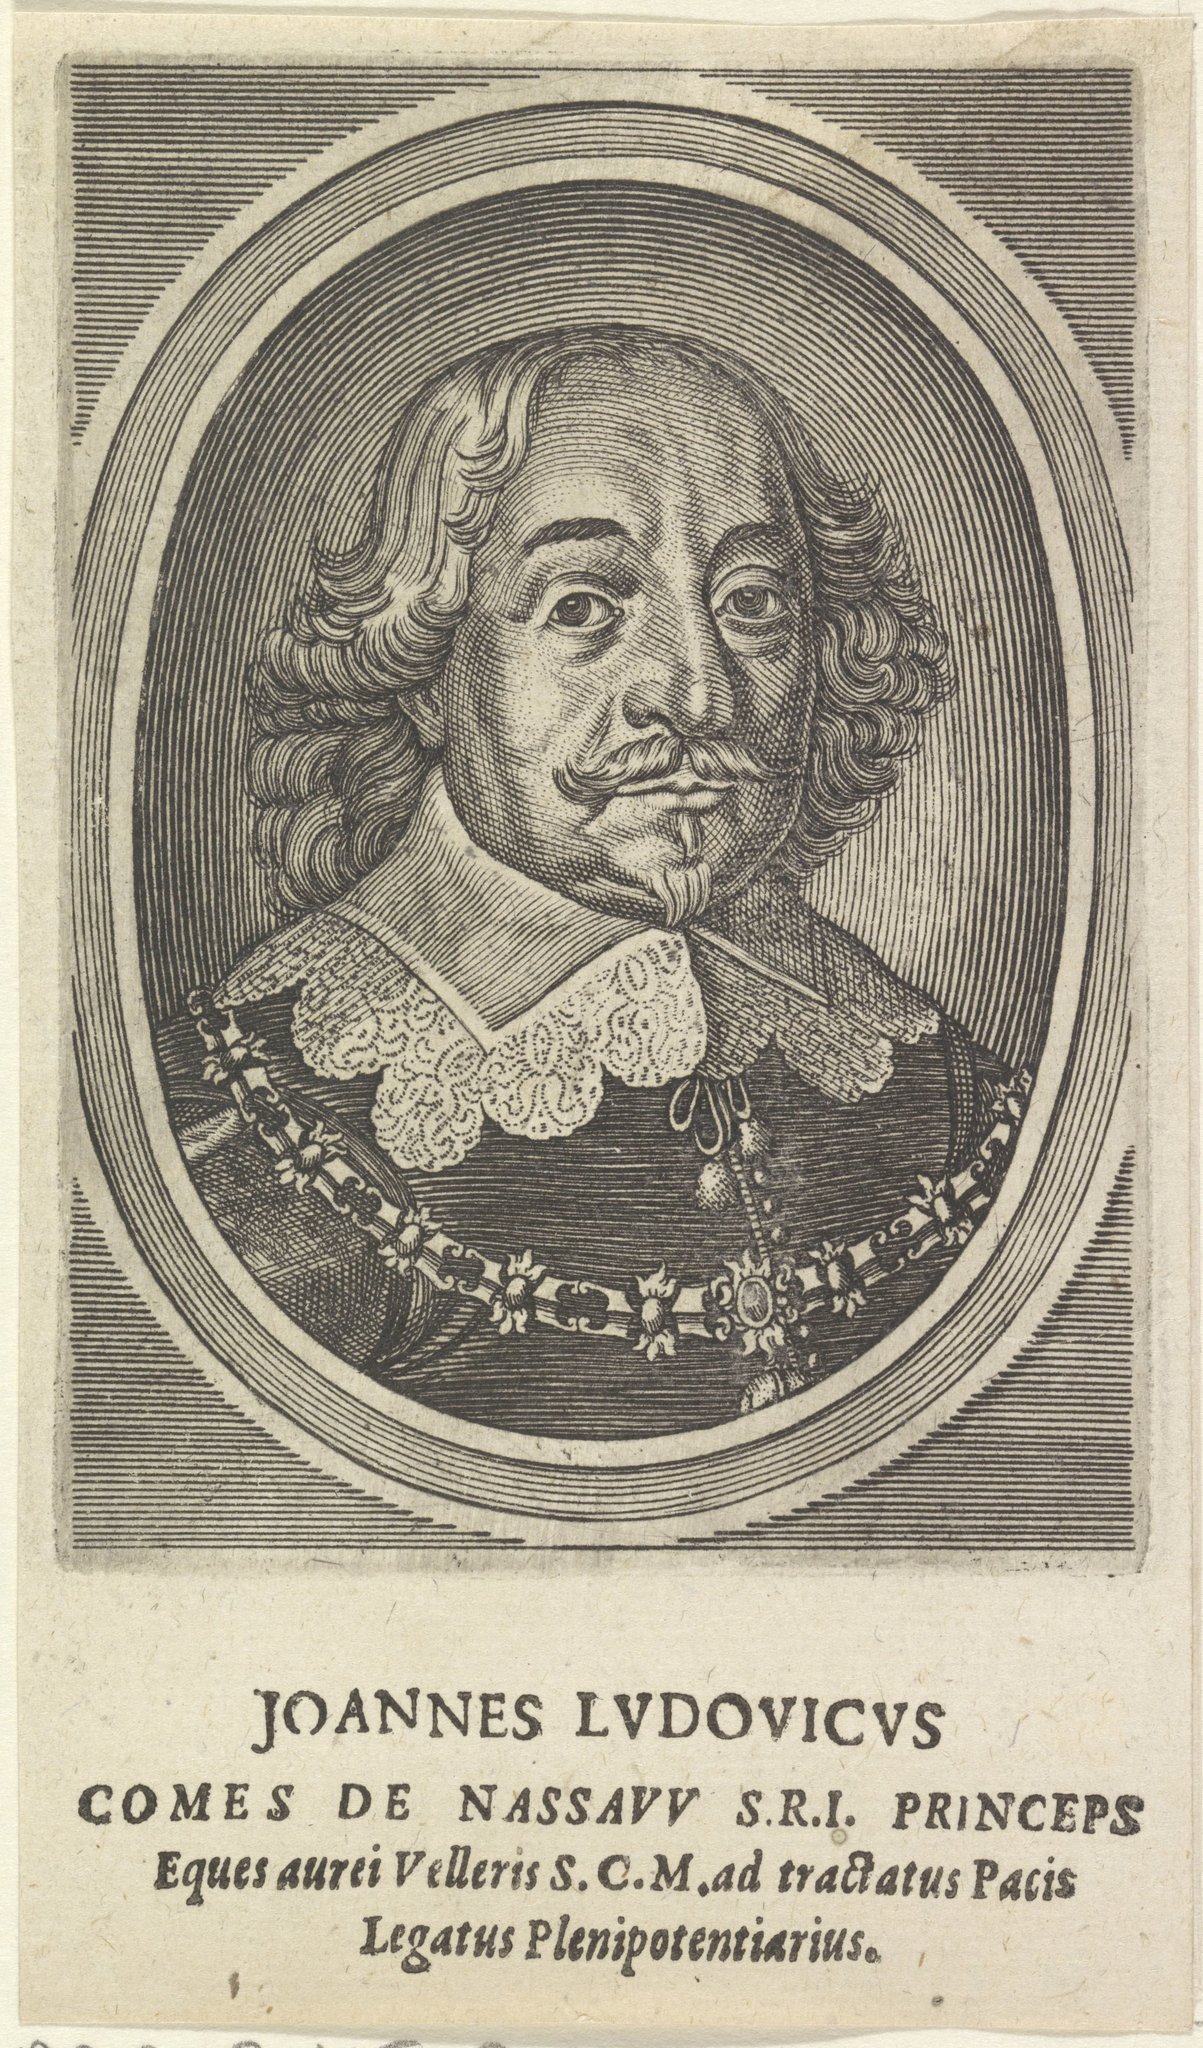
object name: print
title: Portret van Johan Lodewijk, graaf van Nassau-Hadamar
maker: Anonymous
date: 1610-1699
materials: paper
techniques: engraving, etching, letterpress printing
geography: low countries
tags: dillenburg, hadamar, johan lodewijk graaf van nassau-hadamar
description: De hier vermelde titel verwijst naar de hoogst verkregen titel van de geportretteerde, niet per se naar de titel die de geportretteerde op deze voorstelling draagt.